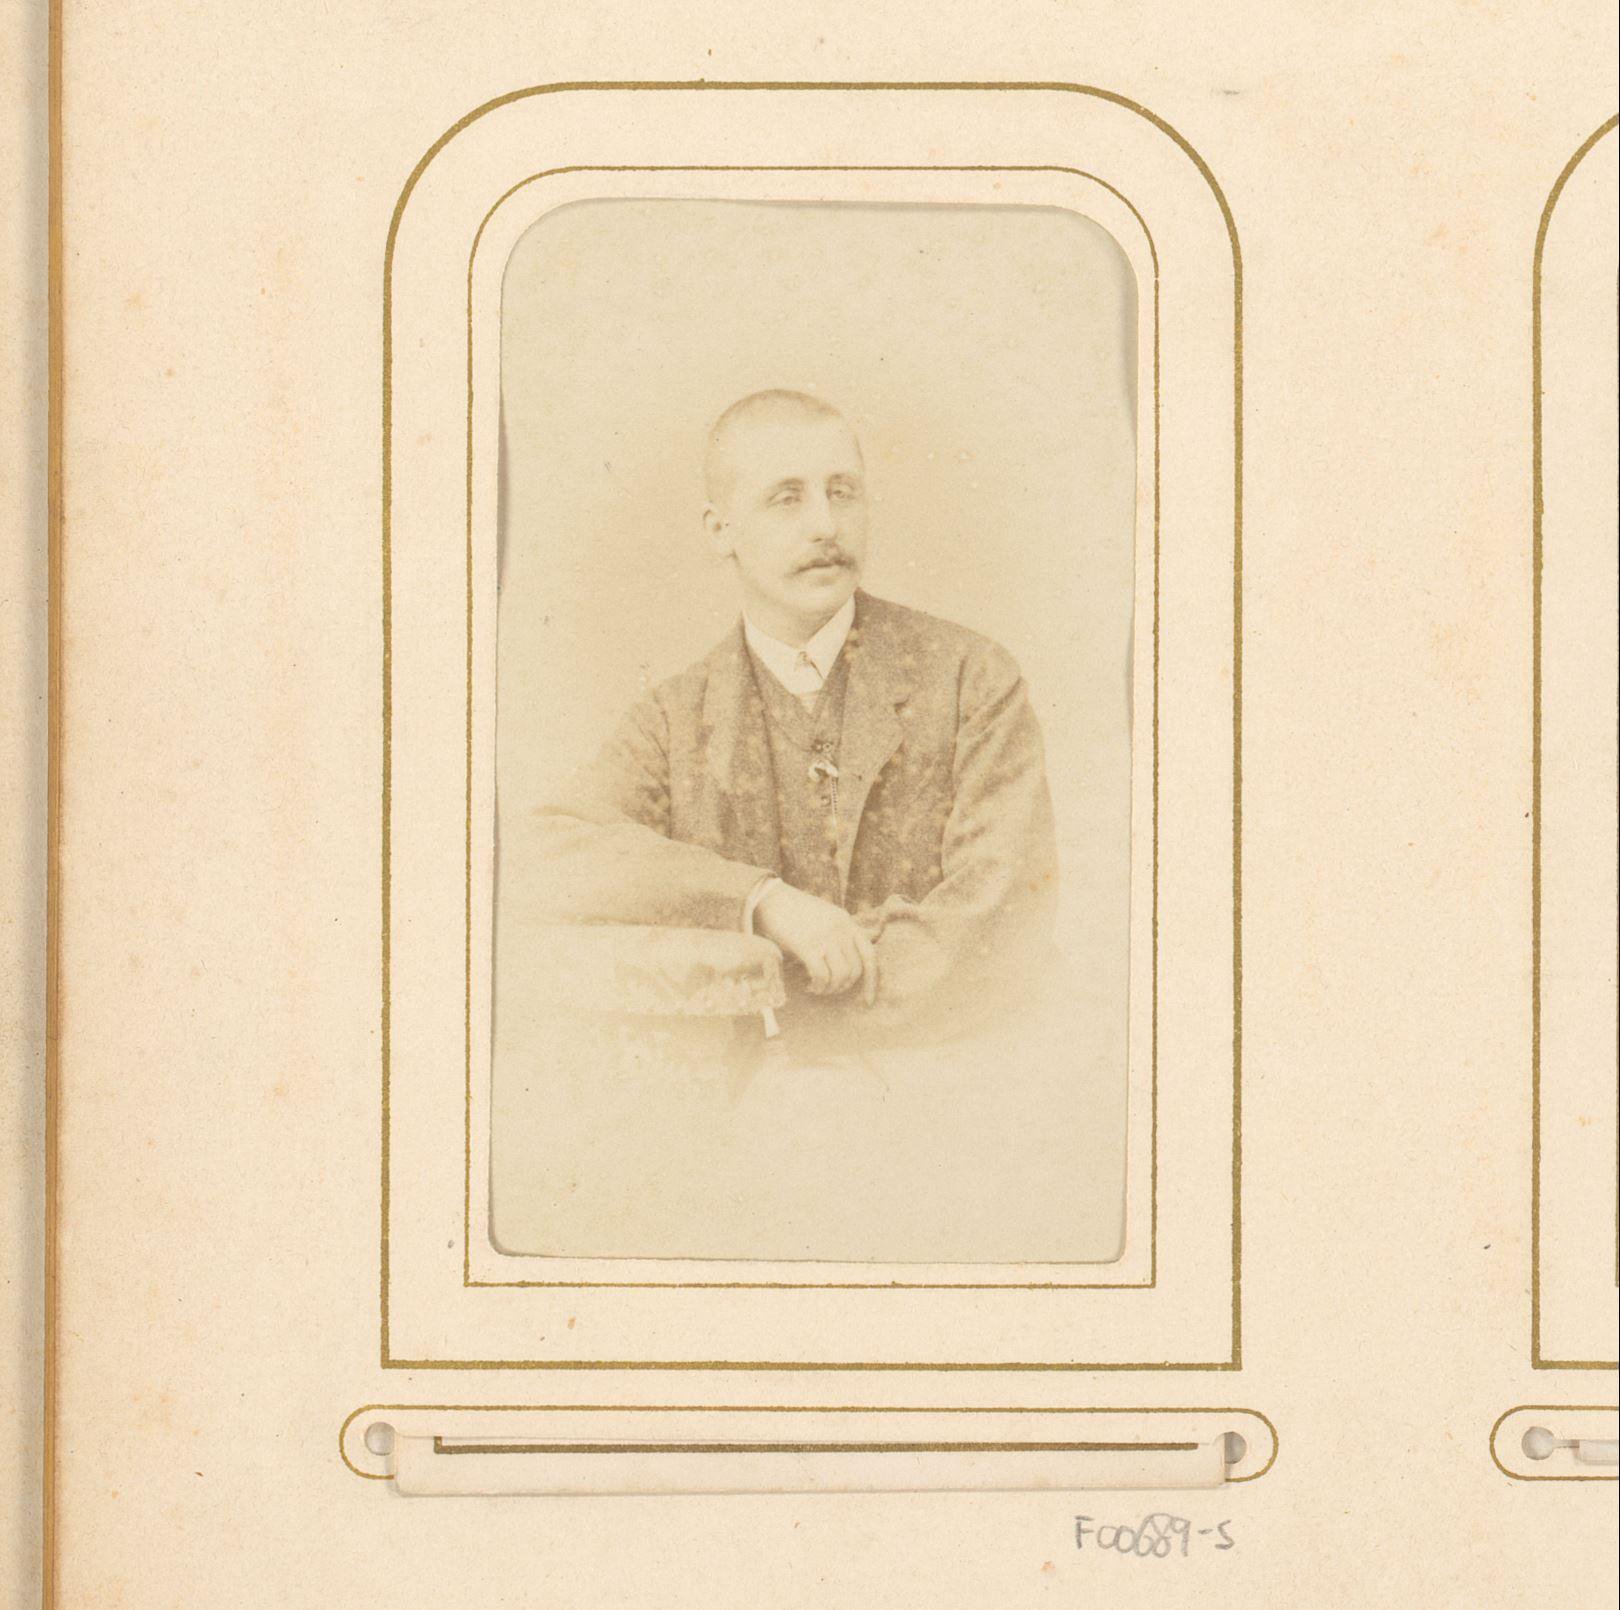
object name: album leaf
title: Portret van een man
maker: joseph silli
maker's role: fotograaf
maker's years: 1826-1886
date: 1860-1900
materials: cardboard, photographic support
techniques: albumen print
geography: nice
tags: historical persons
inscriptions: number: ‘3899’, inscription: ‘Silli/ Nice/ 9, Quai Massena, 9’